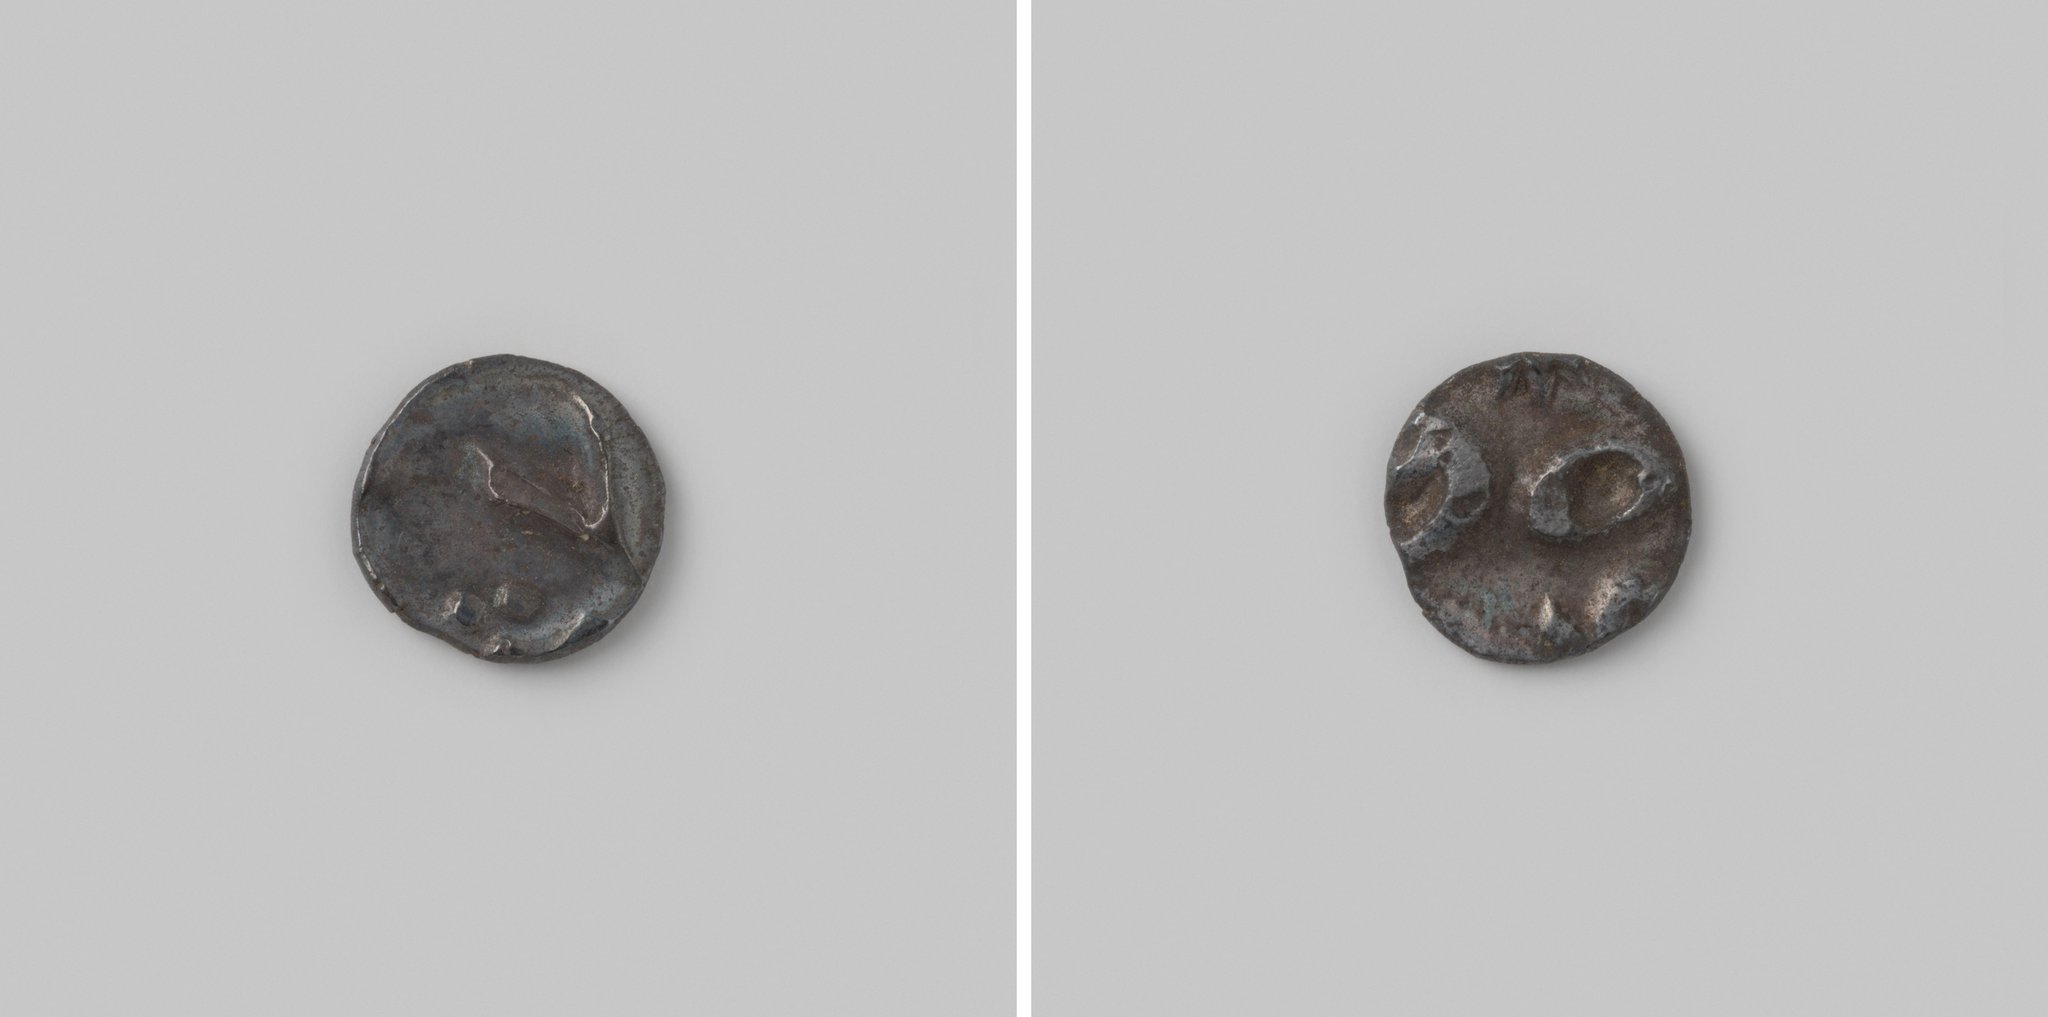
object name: coin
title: 1/64 roepie uit India van sjah Alam II, 1173-1221 [=1759-1806]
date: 1759-1806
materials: silver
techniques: striking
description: Zilveren munt. Voorzijde: in Arabische lettertekens opschrift. Keerzijde: in Arabische lettertekens opschrift met ondeterrmineerbare aanduiding jaartal-aanduiding.